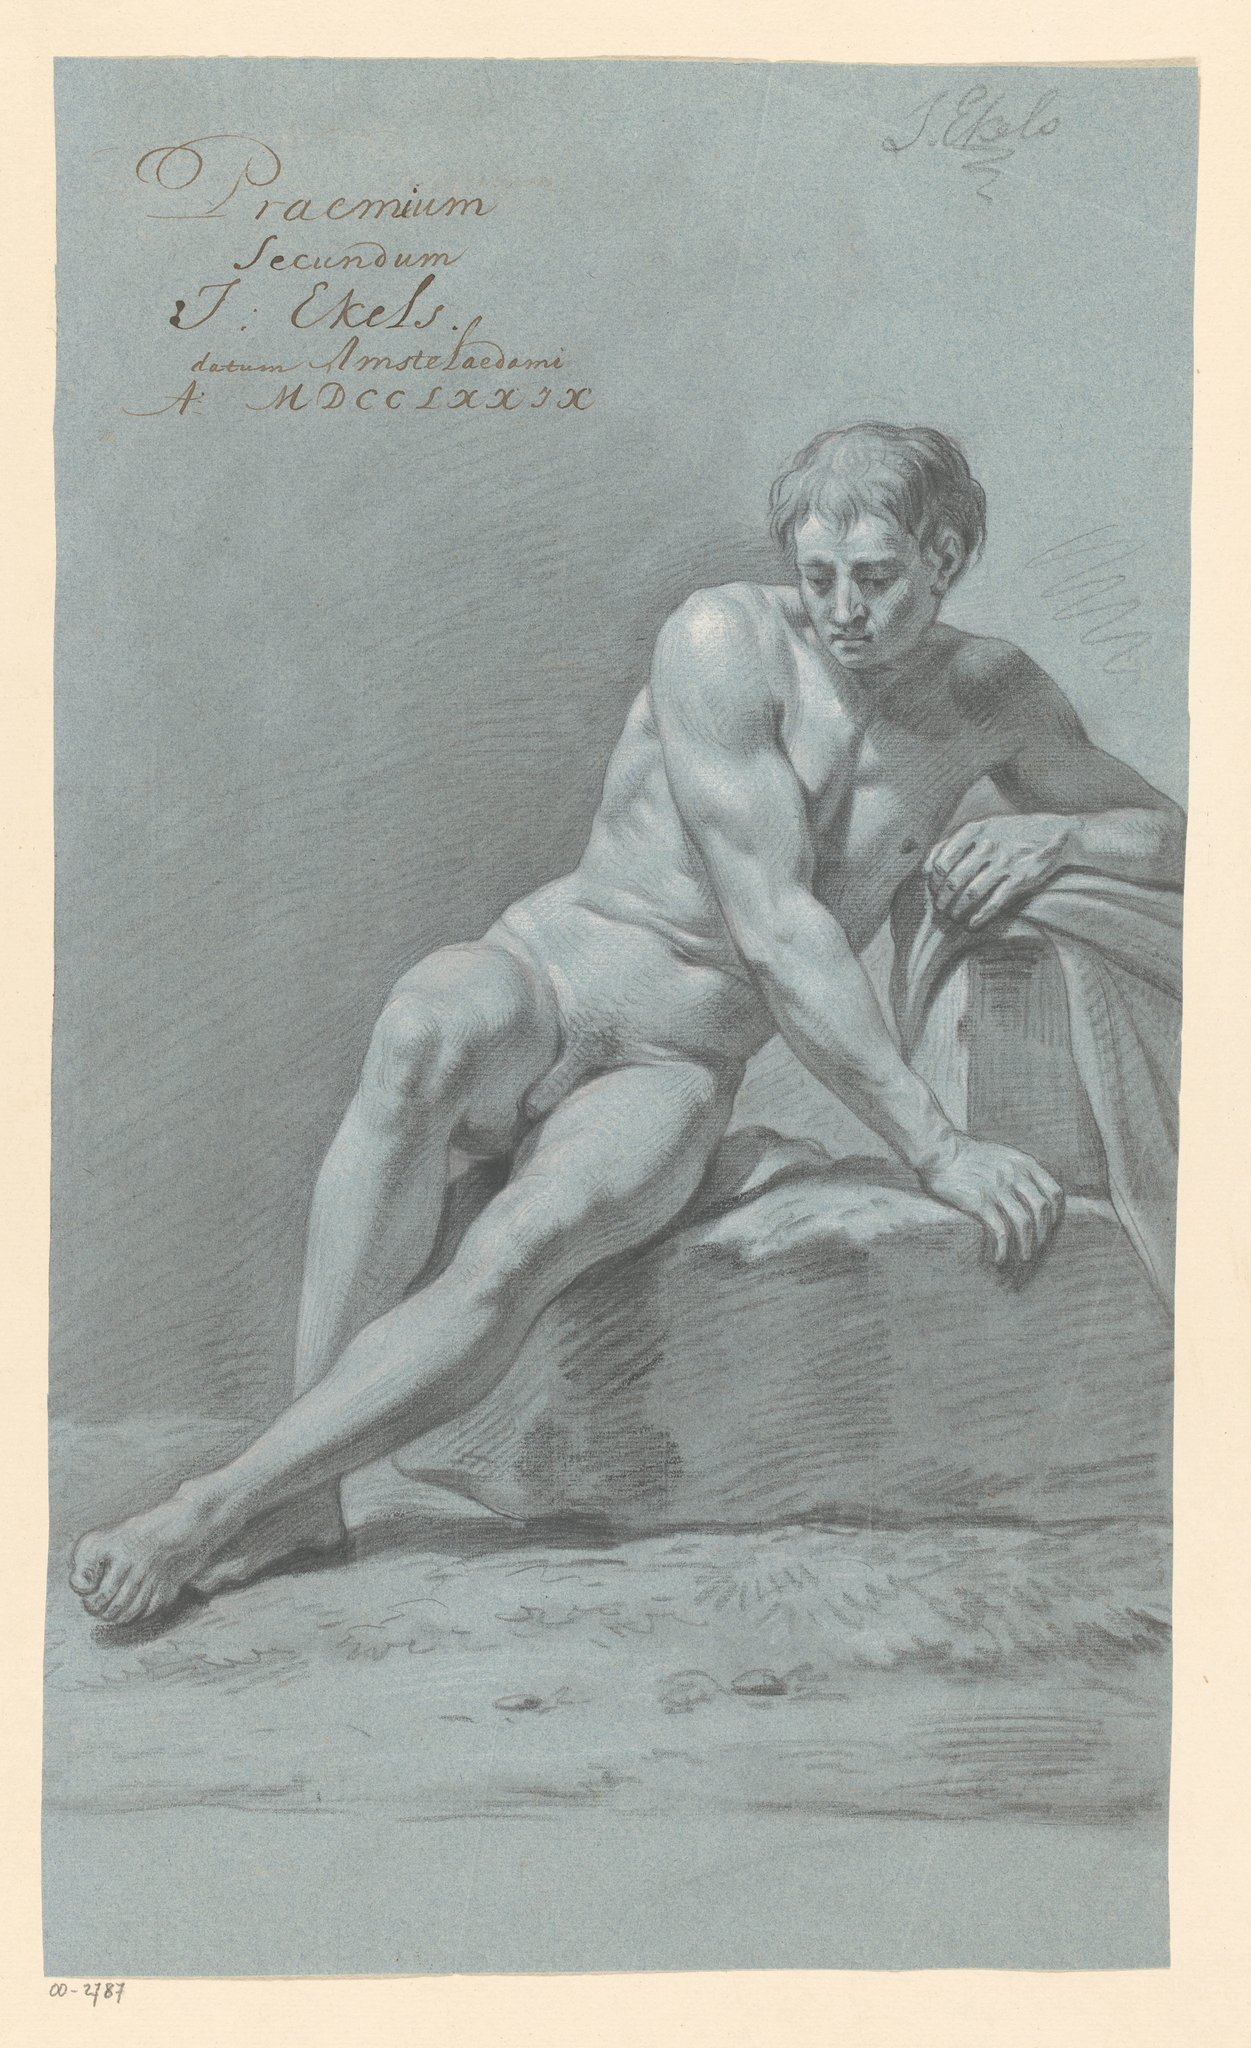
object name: drawing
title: Zittend mannelijk naakt, van voren gezien (2e prijs 1779)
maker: jan ekels (ii)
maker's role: draughtsman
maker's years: 1759-1793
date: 1779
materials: chalk, paper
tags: sitting figure (+ nude human being)